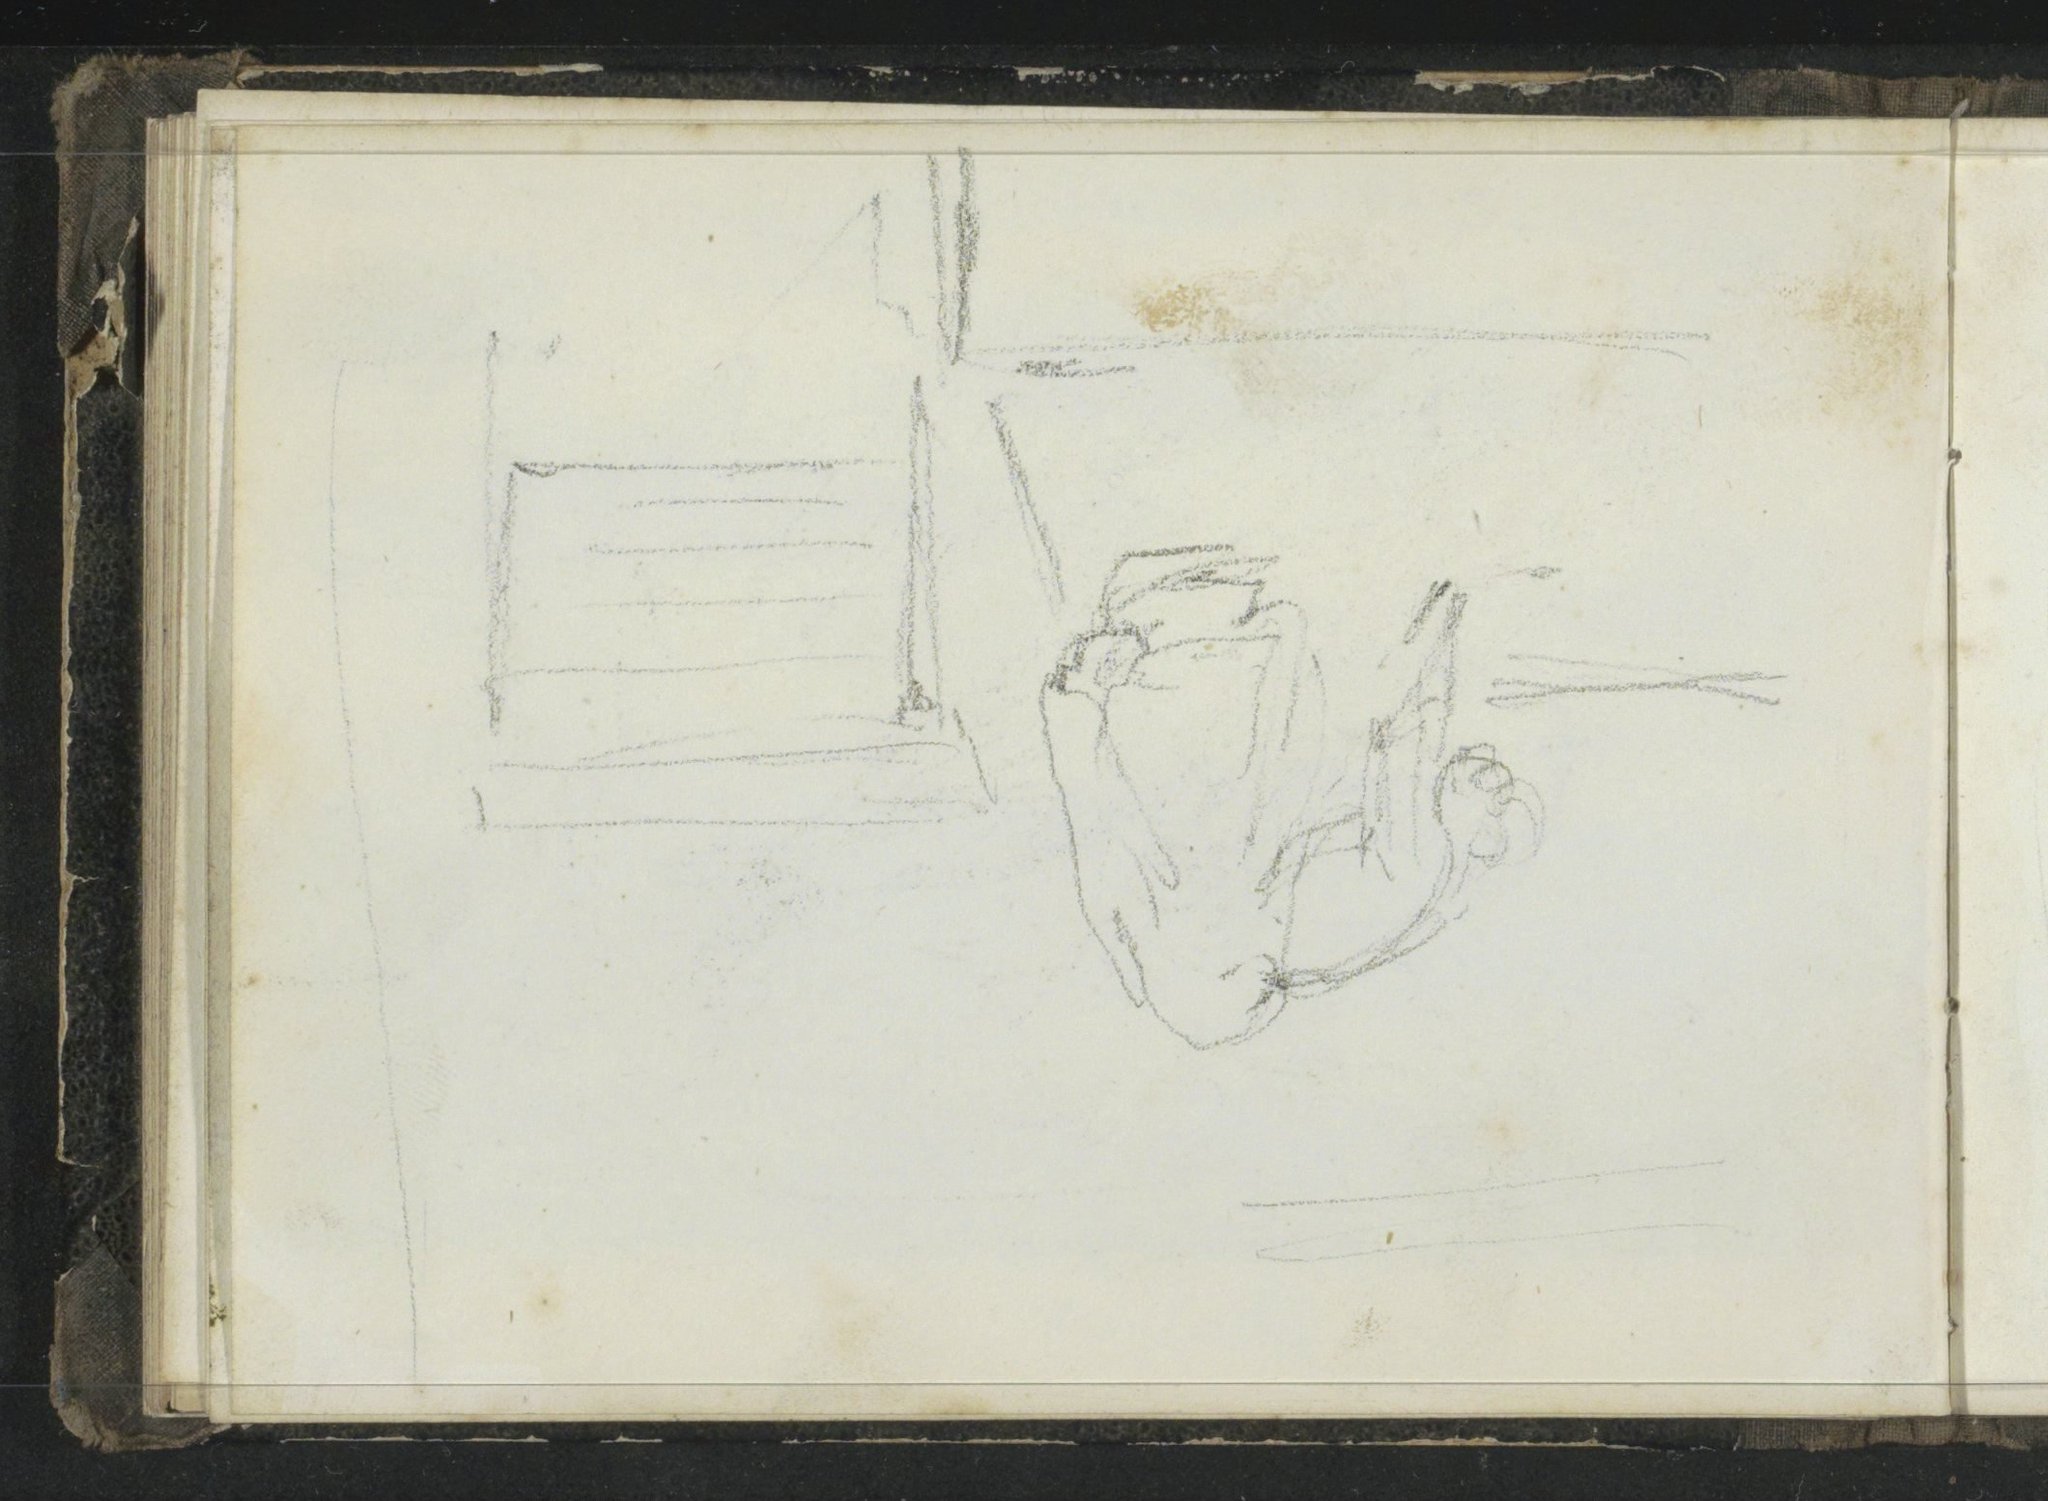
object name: sketchbook leaf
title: Vrouw aan het werk op een stuk grond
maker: theo hanrath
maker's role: draughtsman, painter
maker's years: 1853-1883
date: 1879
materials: paper, pencil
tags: working class, labourers - aa - women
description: De vrouw staat voorovergebogen. Mogelijk werkt zij in een (moes)tuin. Blad 17 verso uit een schetsboek met 27 bladen.